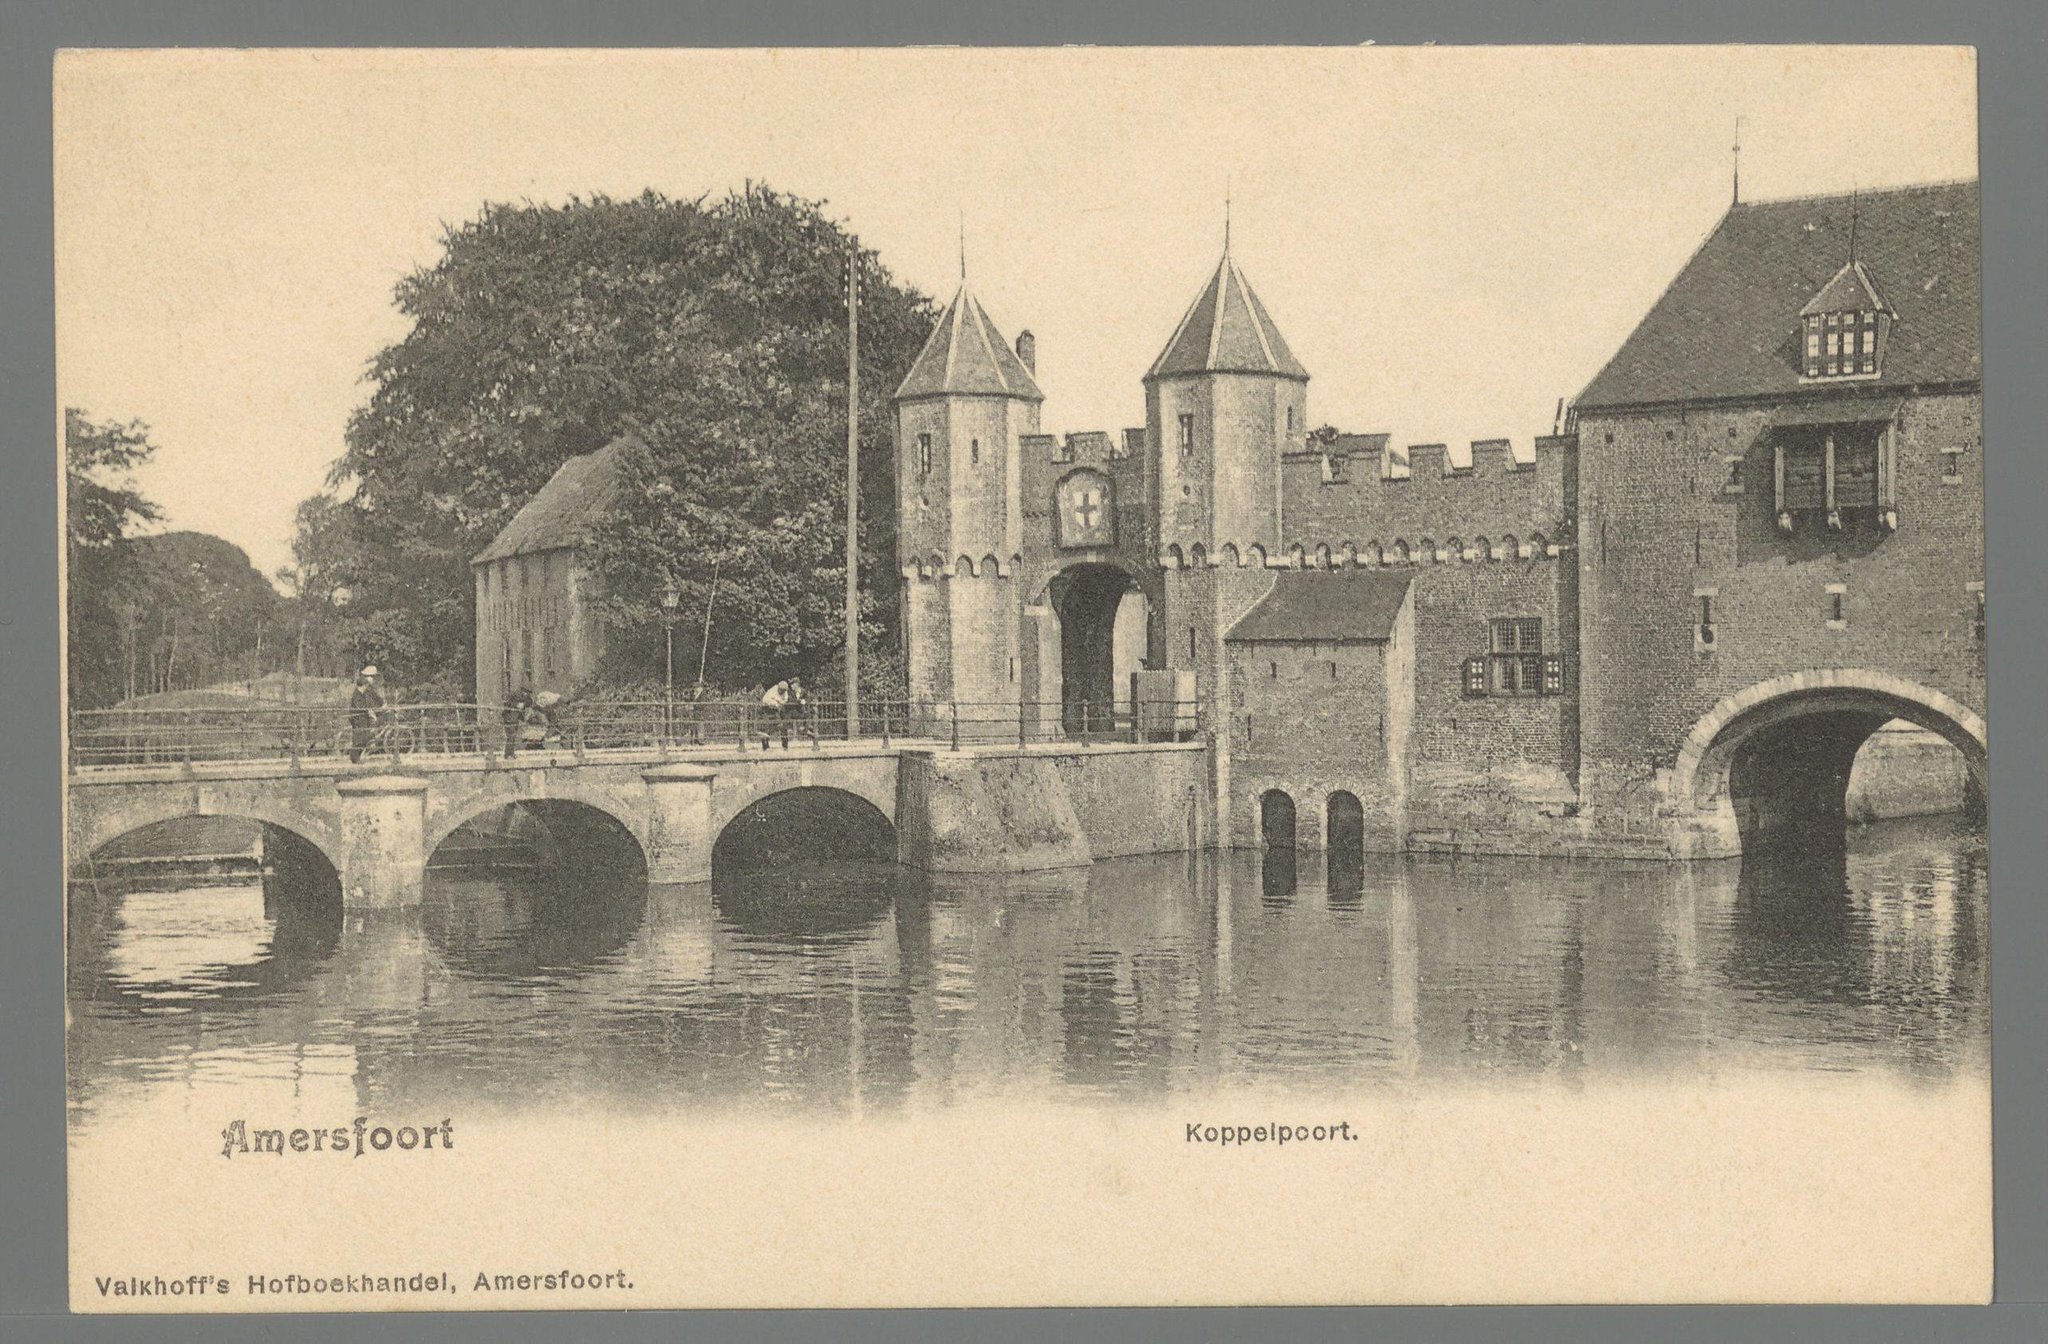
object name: photomechanical print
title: Amersfoort. Koppelpoort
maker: Anonymous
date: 1897-1905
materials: cardboard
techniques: photograph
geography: amersfoort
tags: watergate, canals, waters (in city), city-gate